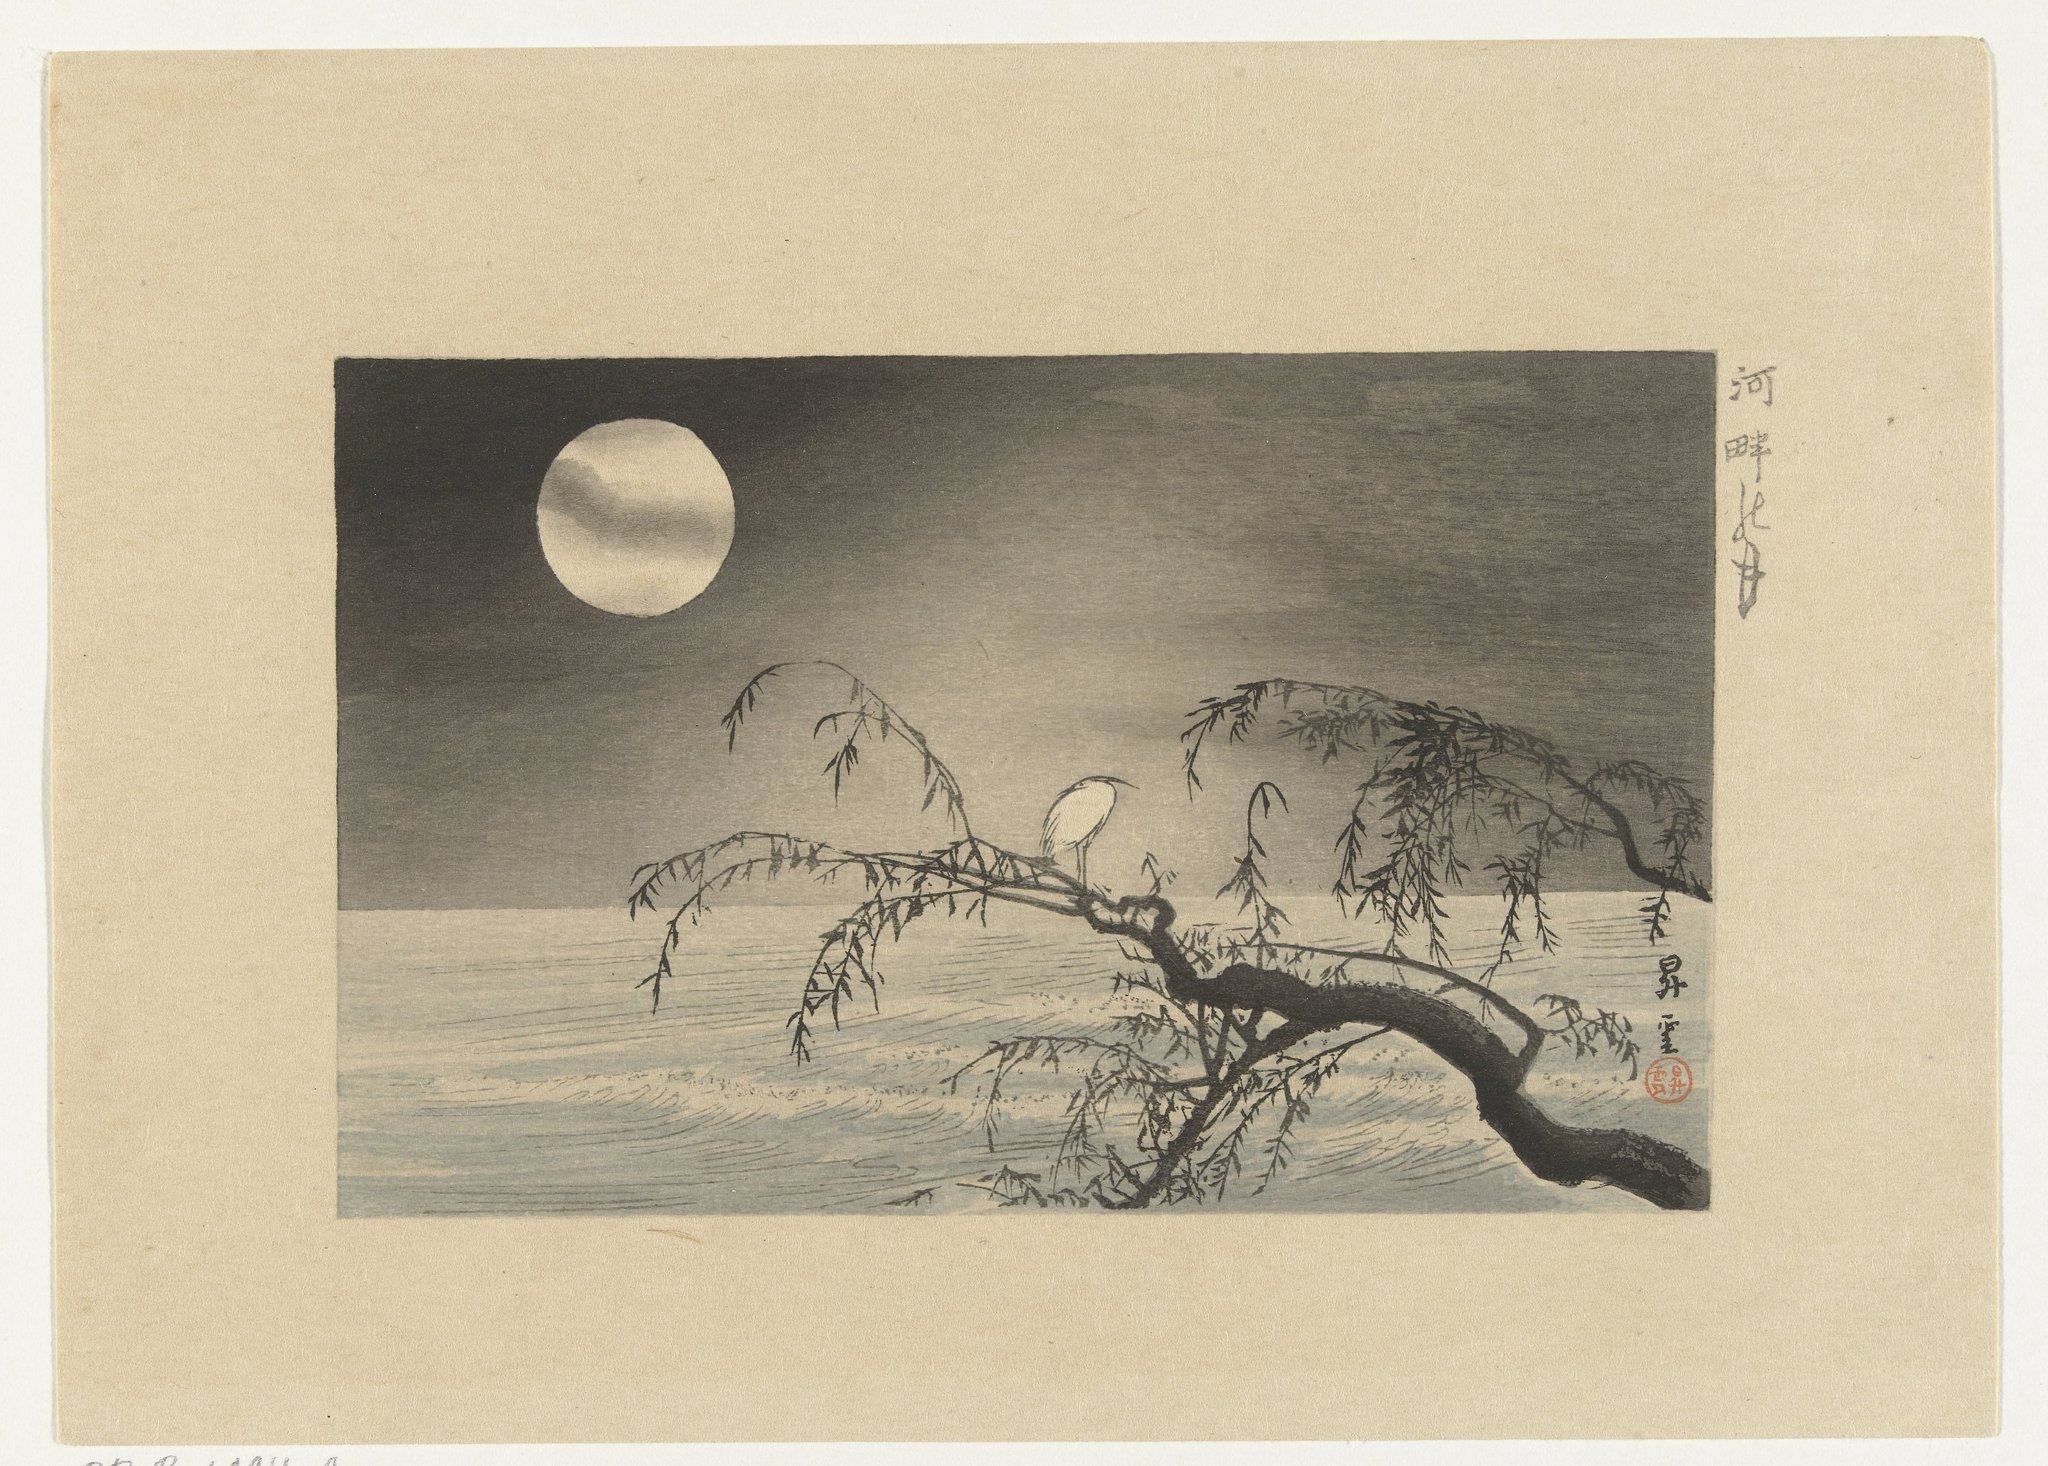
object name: print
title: Volle maan boven rivier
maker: yamamoto shoun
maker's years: 1870-1965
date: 1890-1950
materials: paper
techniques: woodcut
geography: japan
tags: shore-birds and wading-birds: heron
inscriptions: collector's mark: Lugt 2760, collector's mark: Lugt 2228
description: Reiger op tak boven rivier; bij volle maan